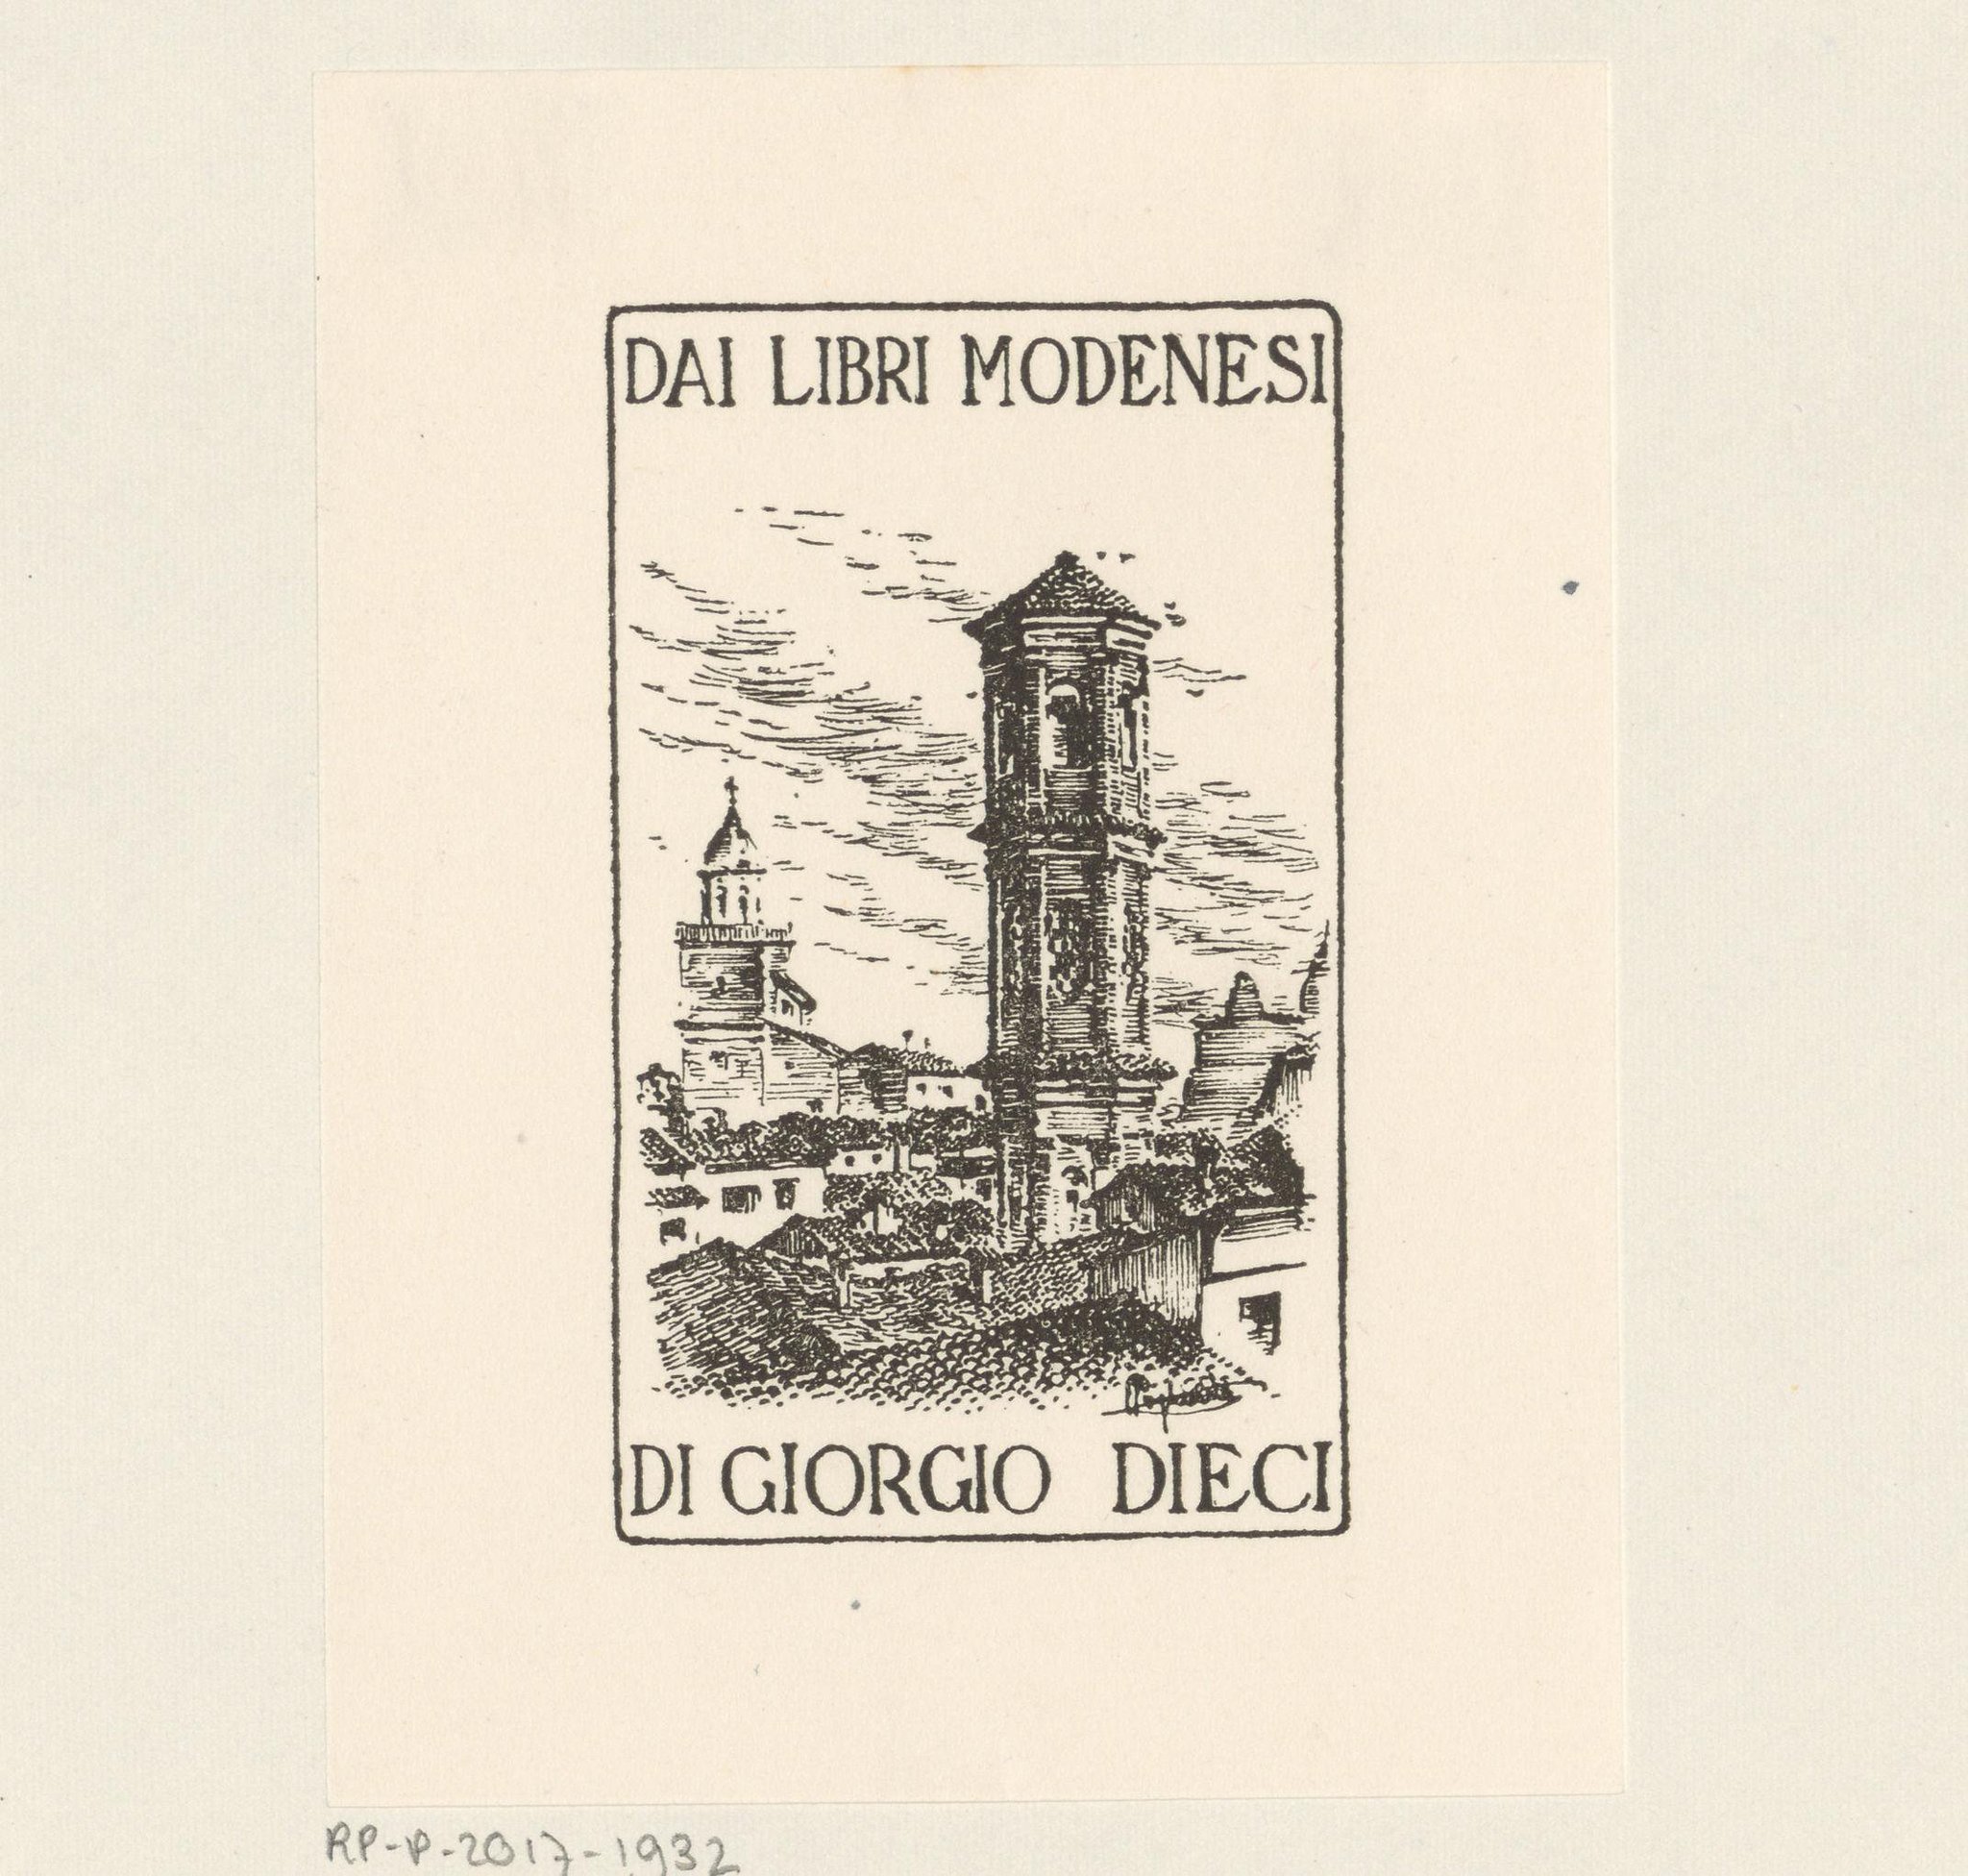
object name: bookplate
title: Ex libris van Giorgio Dieci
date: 1900-1999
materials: paper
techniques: printing block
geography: italy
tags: parts of church exterior and annexes: campanile, prospect of city, town panorama, silhouette of city